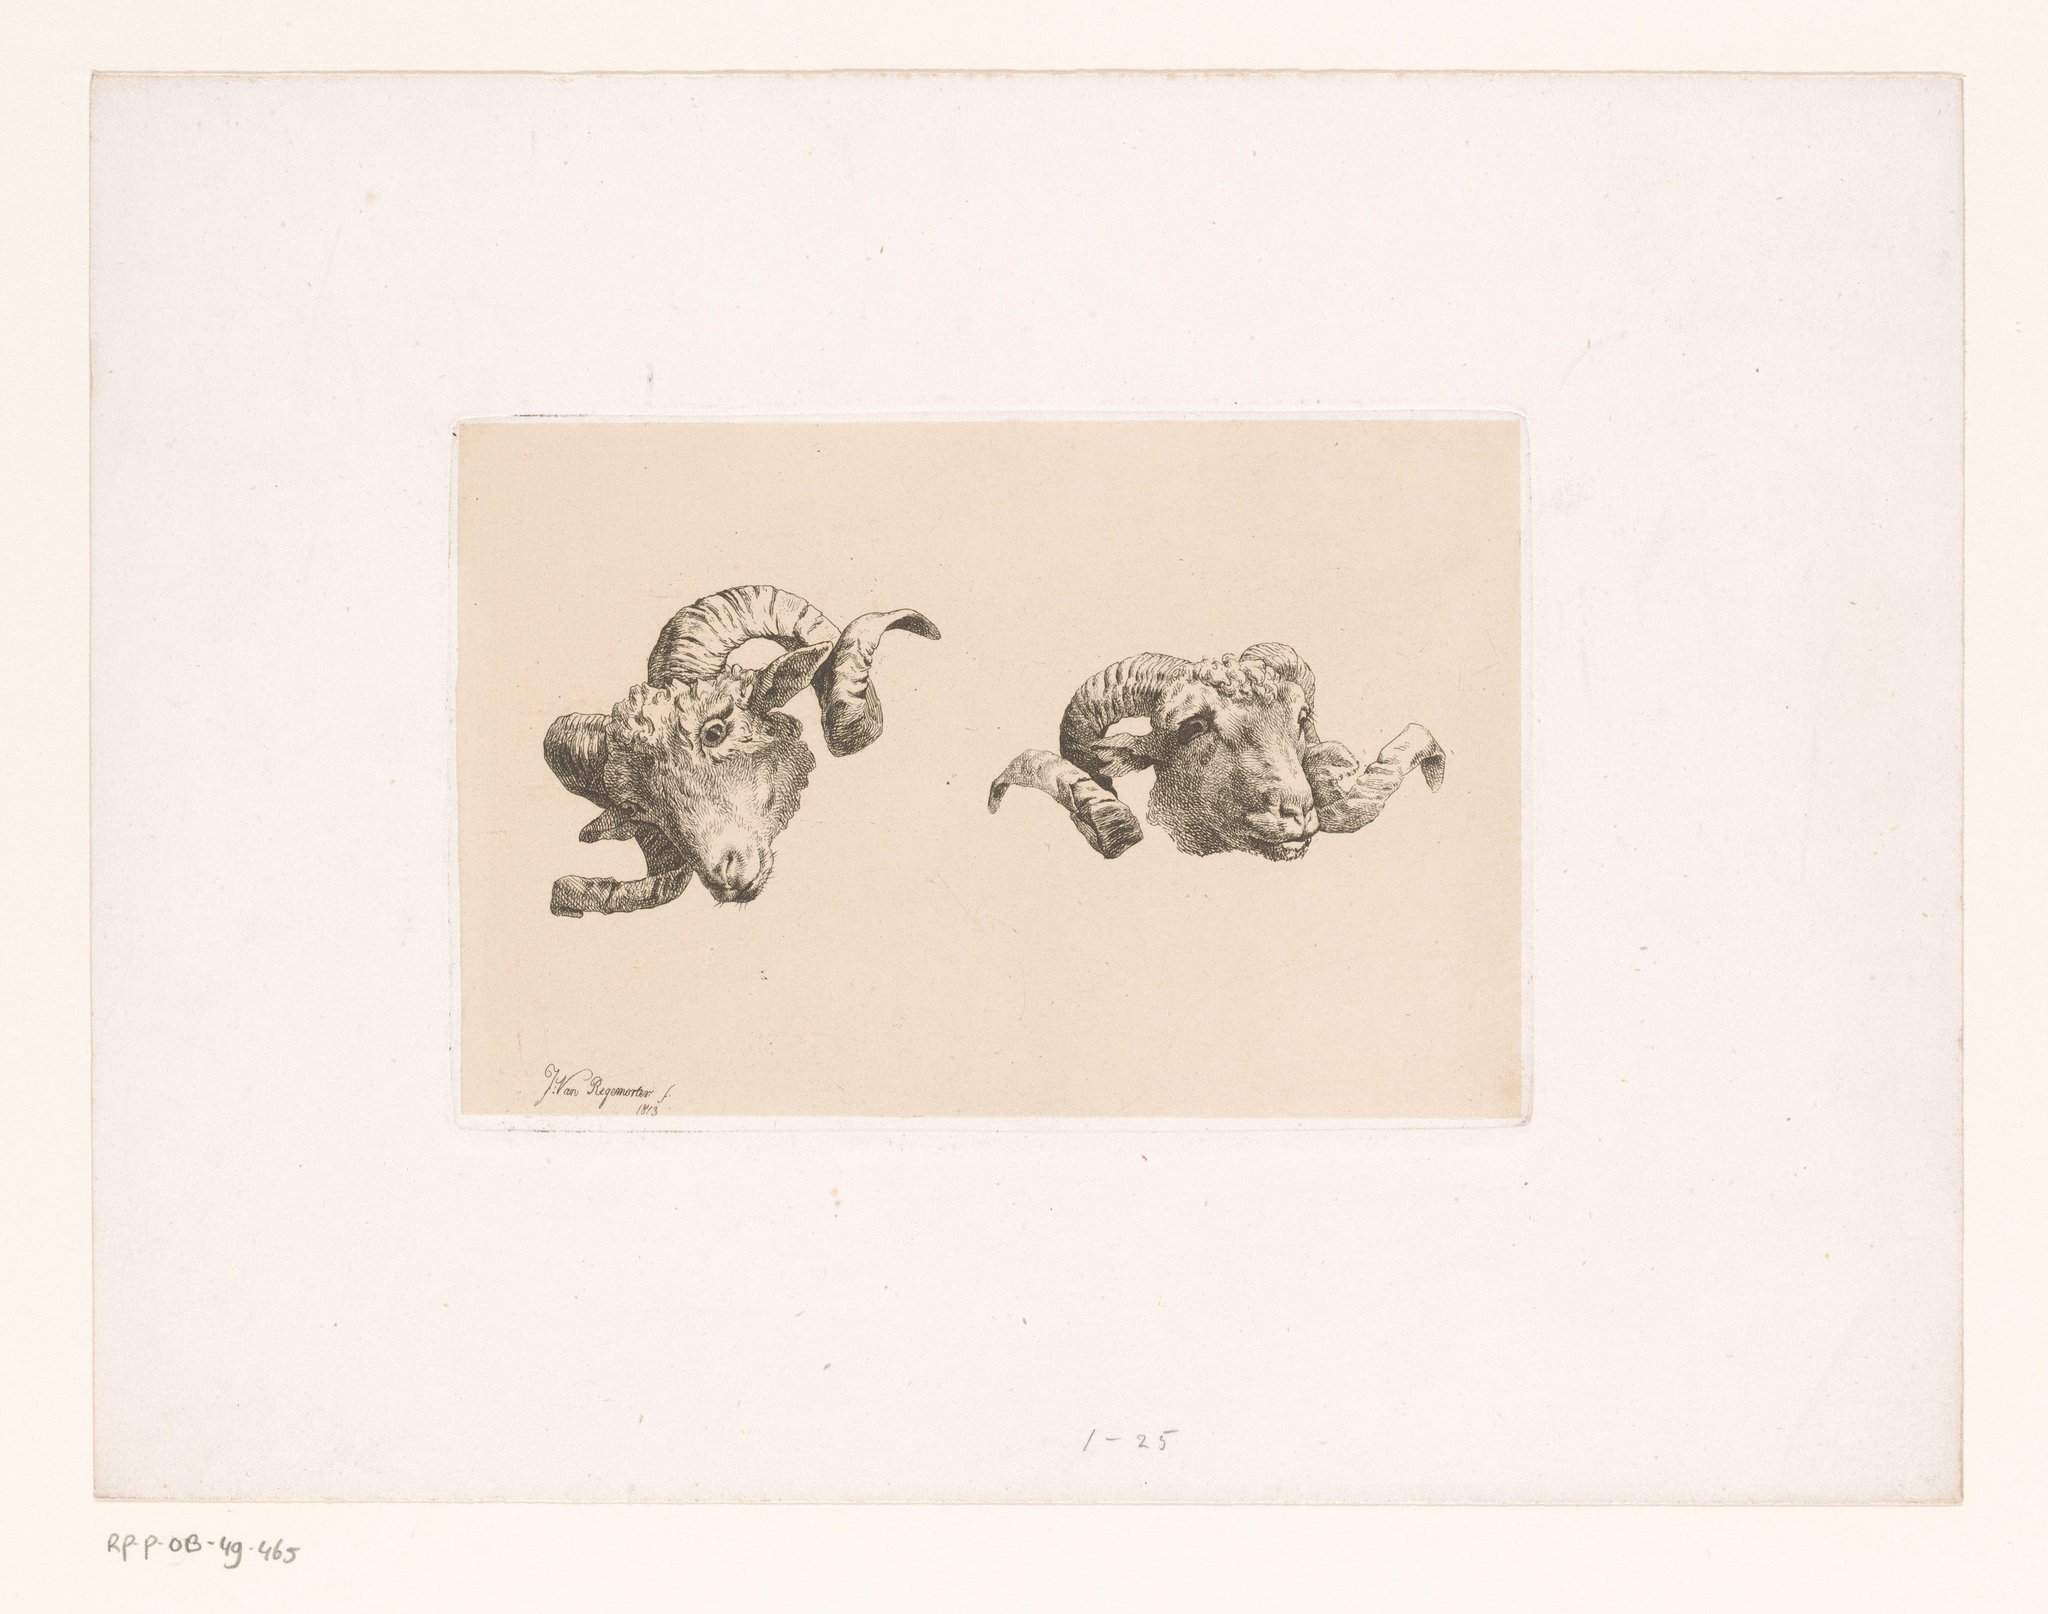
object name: print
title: Twee ramskoppen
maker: ignatius josephus van regemorter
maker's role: conservator, painter, print maker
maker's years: 1785-1873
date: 1813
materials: paper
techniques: etching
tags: ram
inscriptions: date